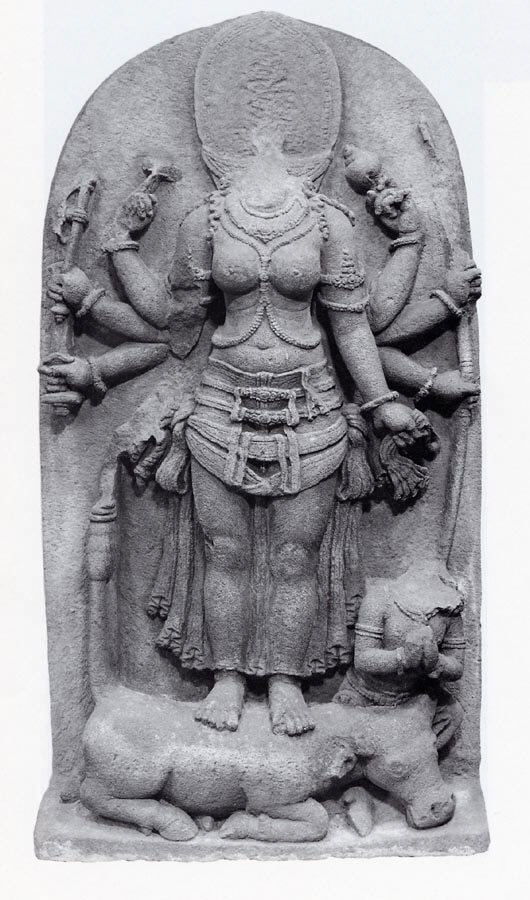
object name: stele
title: The Goddess Durga Victorious over the Buffalo Demon, Mahisha (Mahishasuramardini)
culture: indonesian, javanese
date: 801-900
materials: stone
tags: buffalos,demons,durga,hinduism